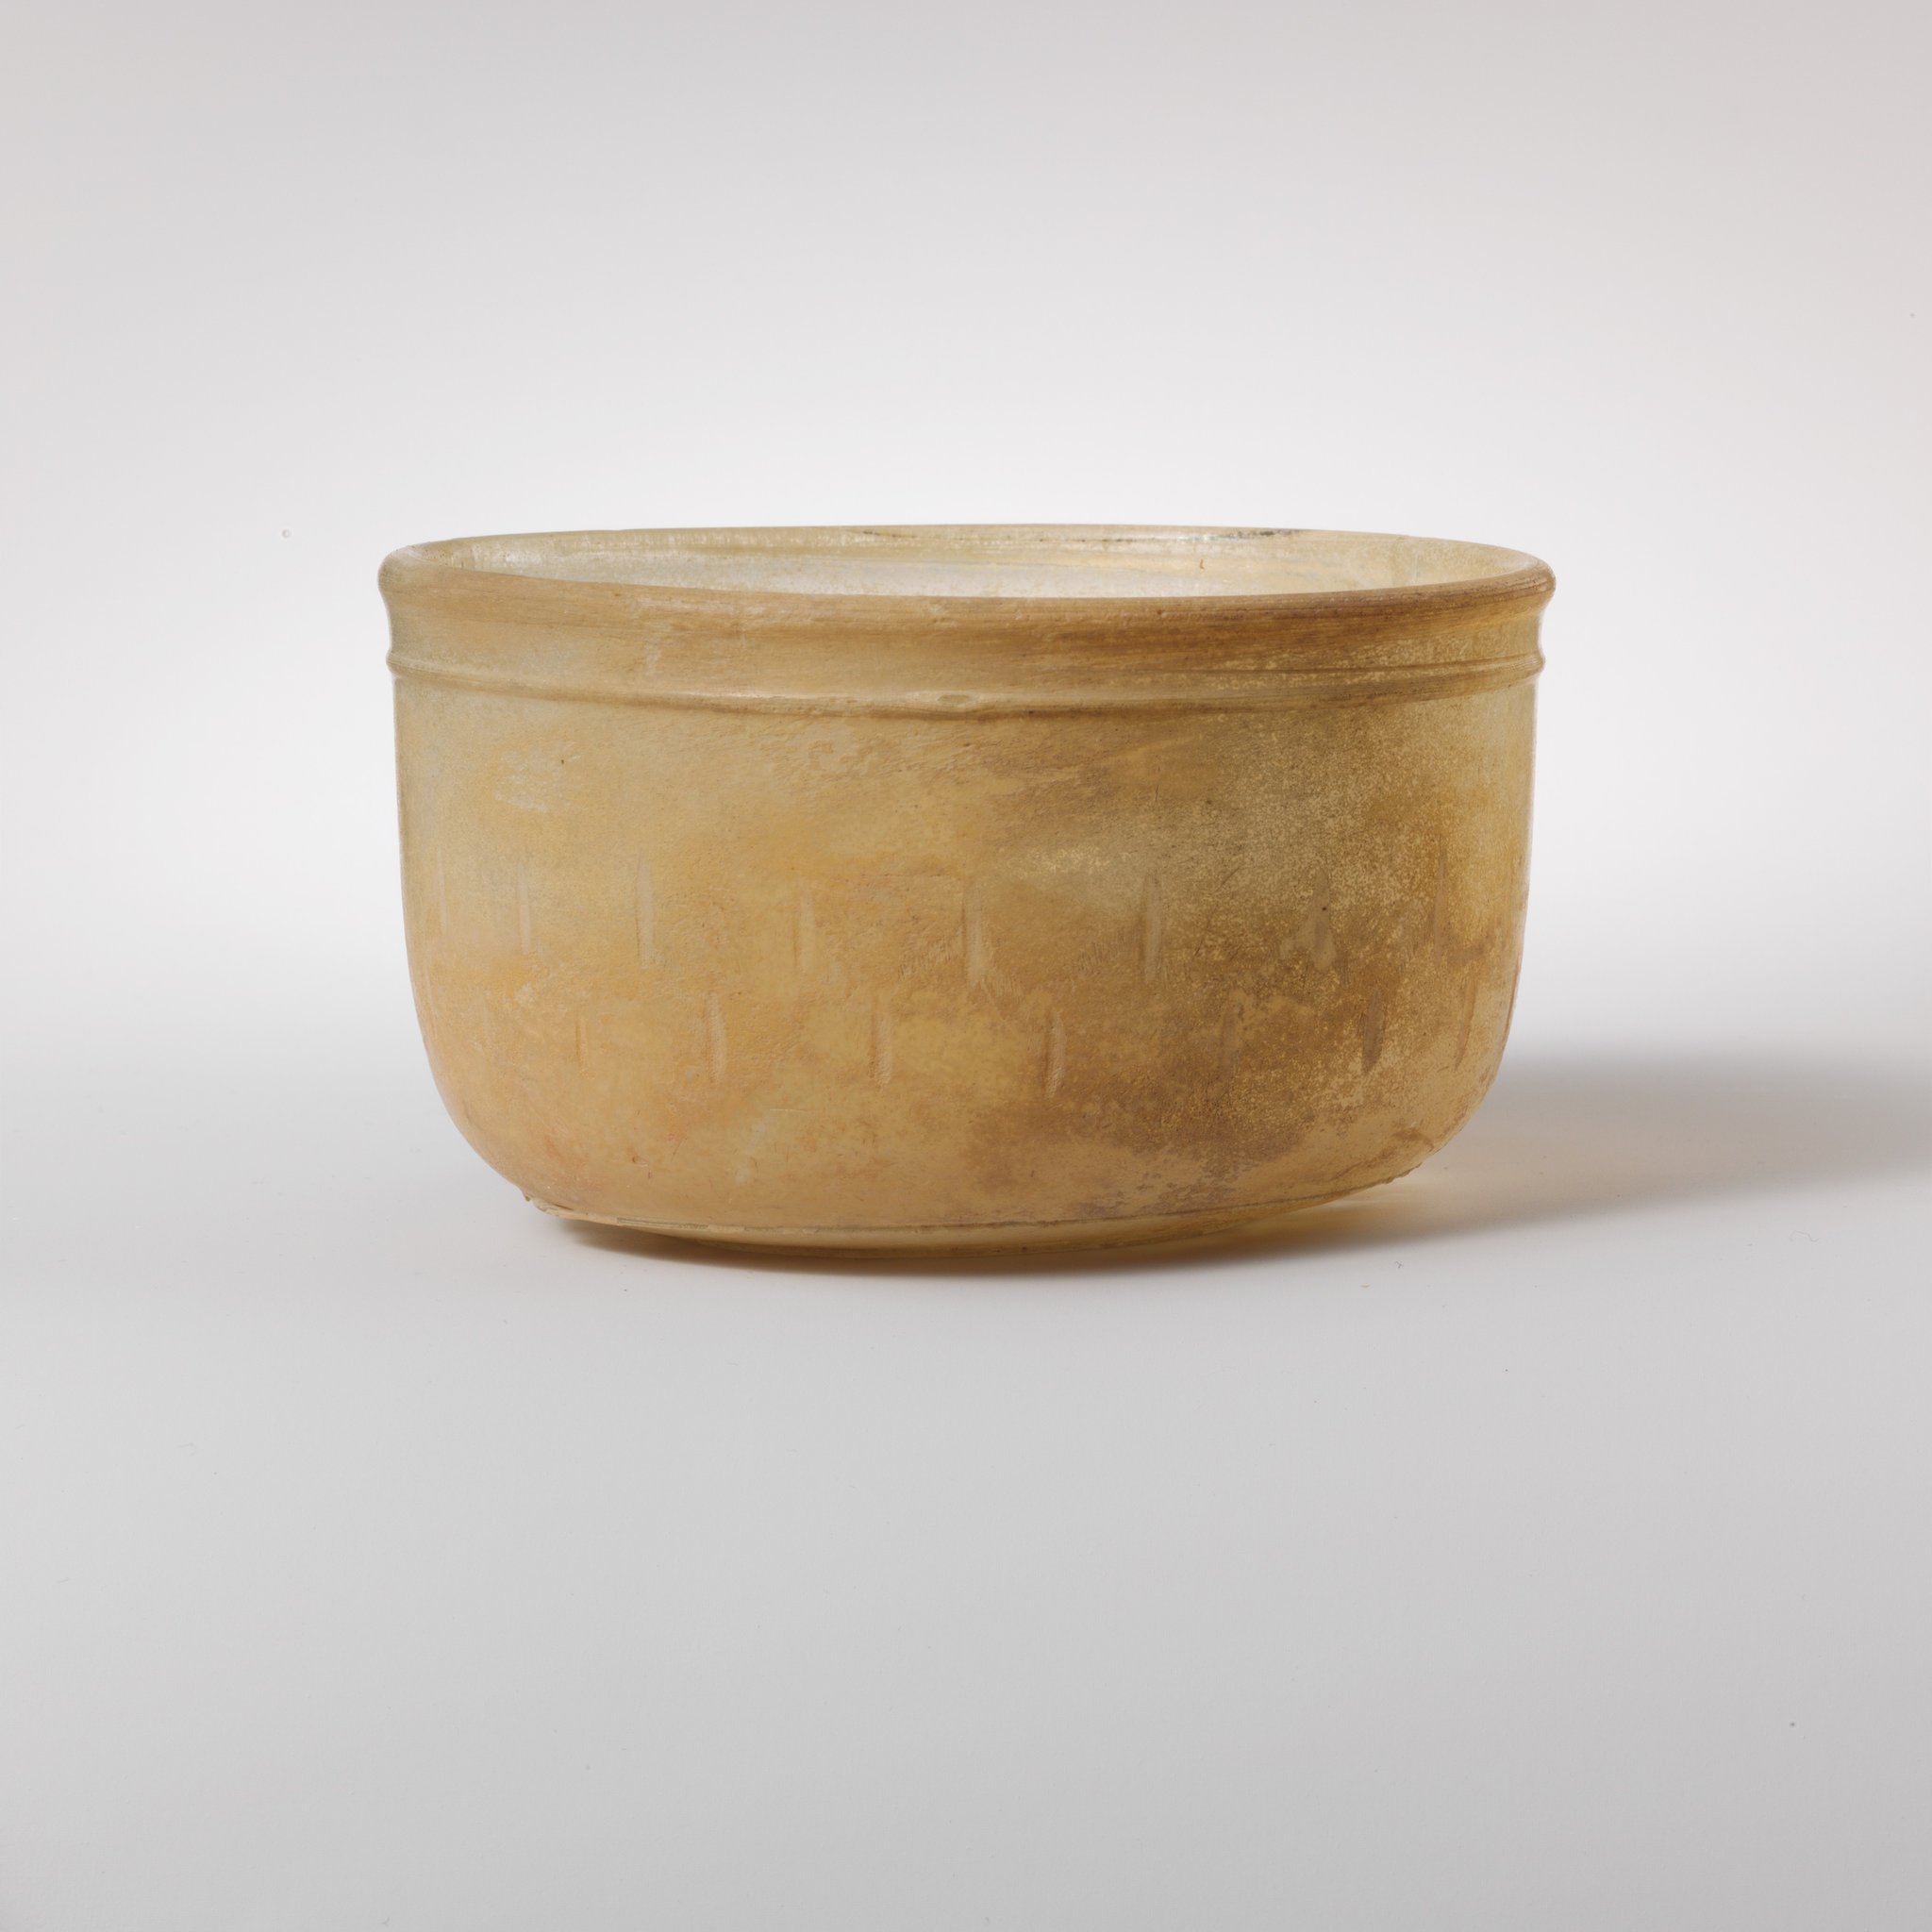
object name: bowl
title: Glass bowl with cut decoration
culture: roman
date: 101-300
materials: glass